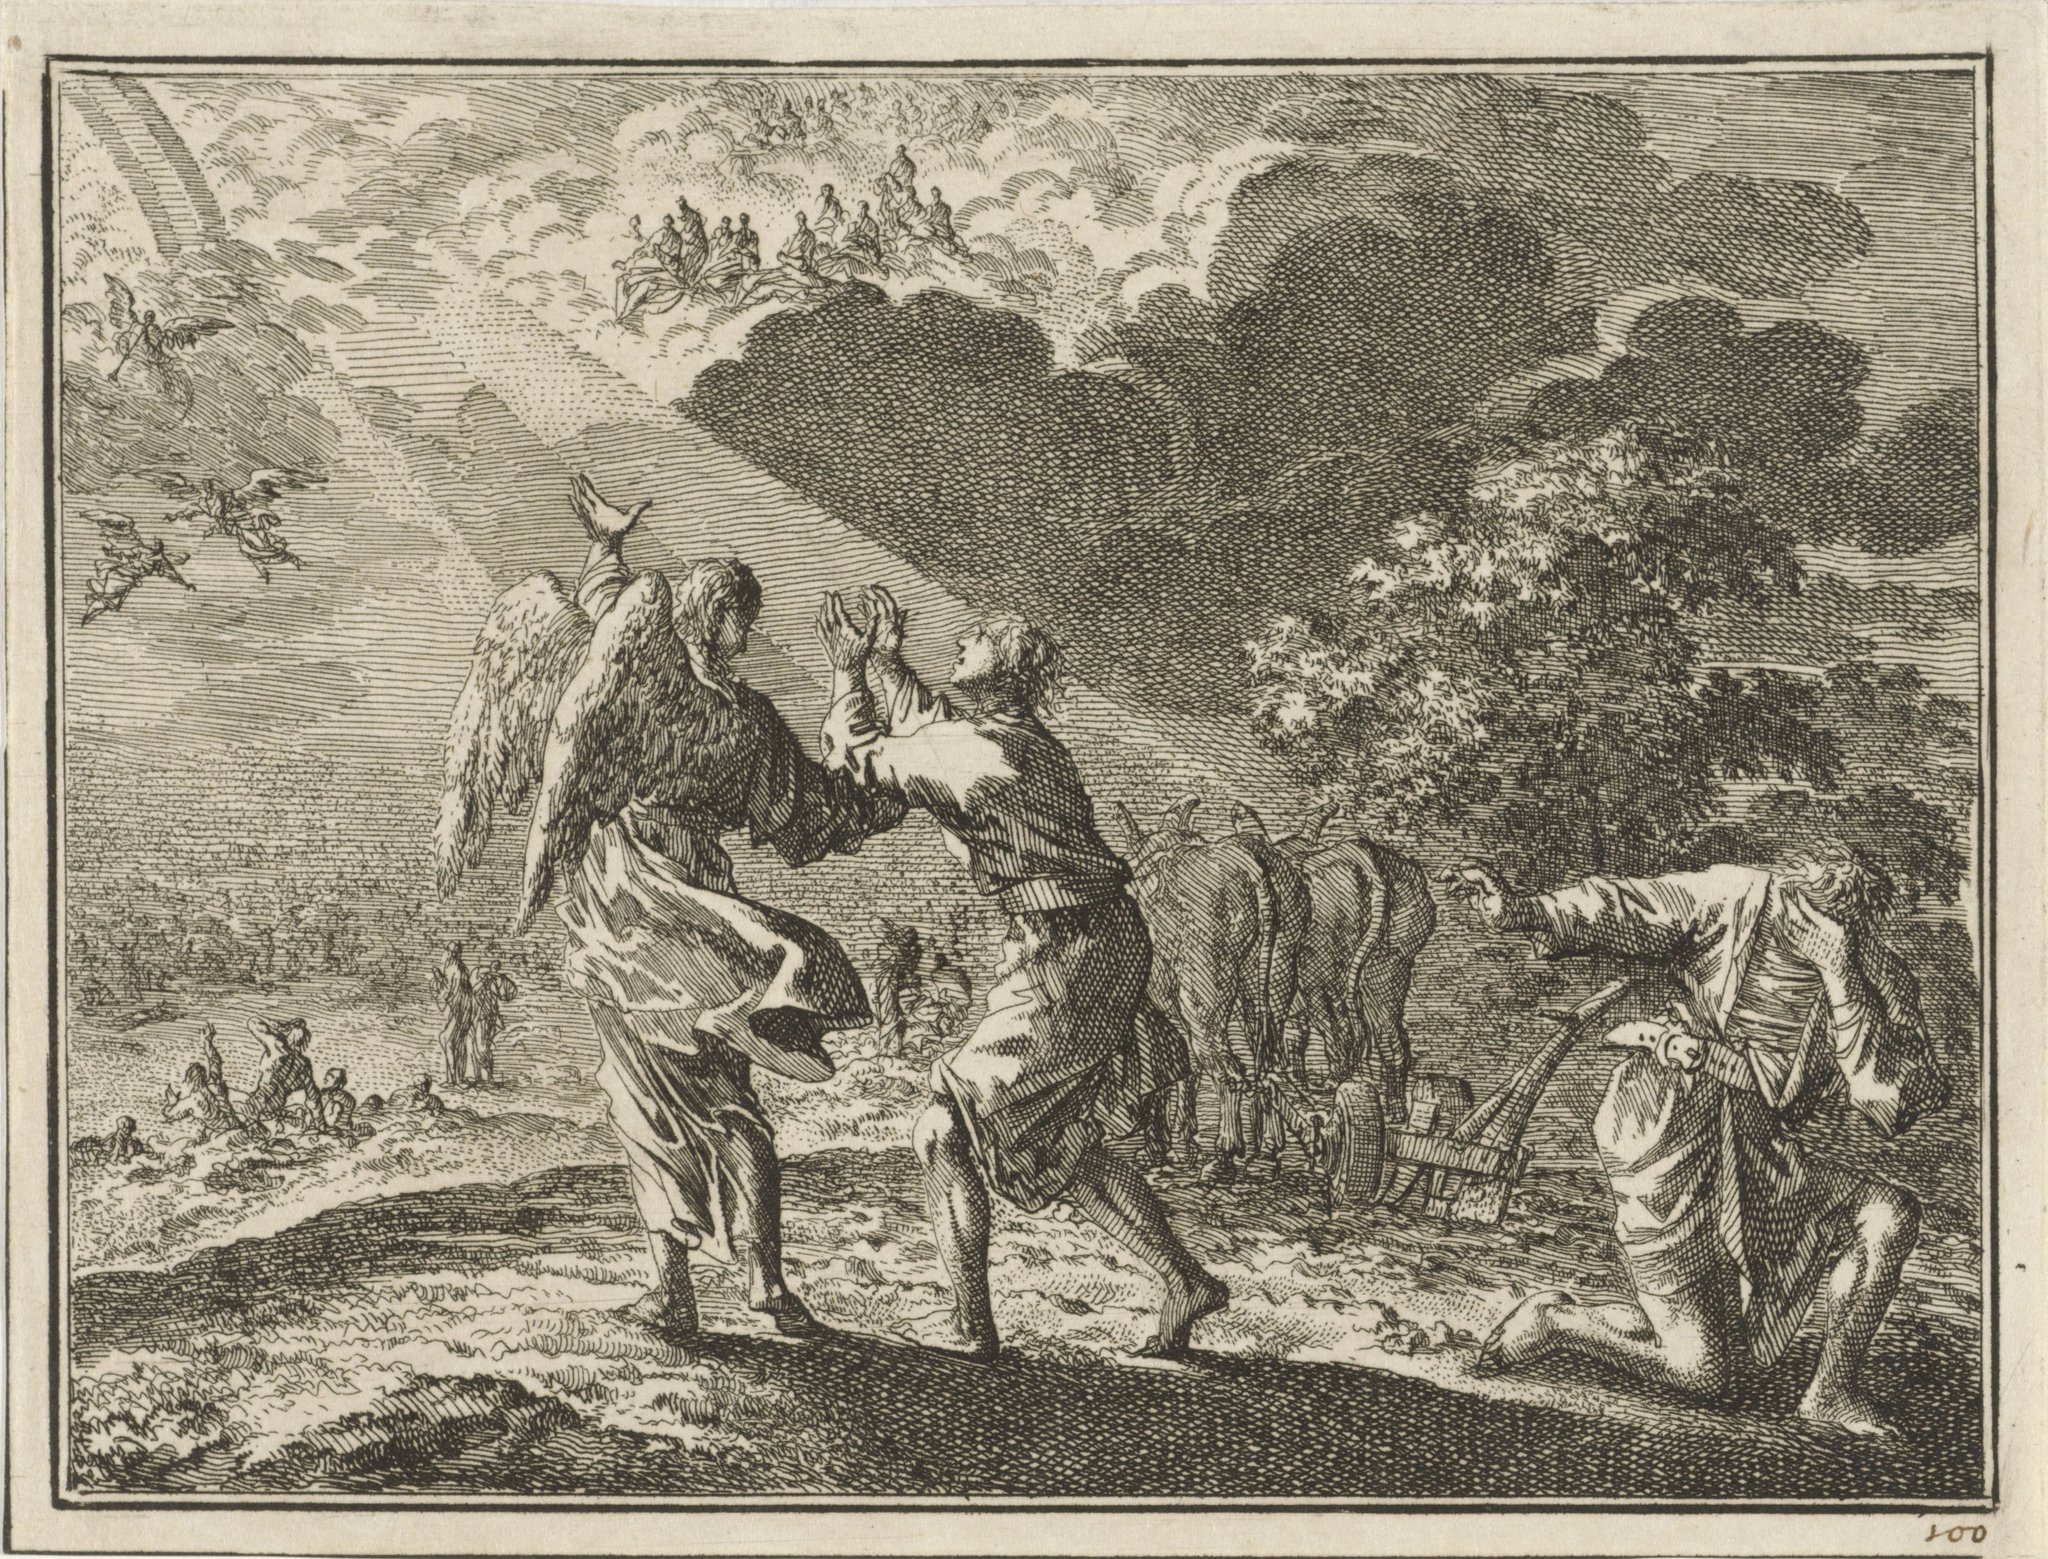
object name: print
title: Van twee op een akker werkende personen wordt één aangenomen en de ander verlaten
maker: jan luyken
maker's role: draughtsman, print maker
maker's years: 1649-1712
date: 1712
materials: paper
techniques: etching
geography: amsterdam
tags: ploughing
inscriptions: number: ‘100’, collector's mark: Lugt 2228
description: Proefdruk van illustratie uit: Luyken, Jan. De schriftuurlyke geschiedenissen en gelykenissen van het Oude en Nieuwe Verbond, 2 delen. Amsterdam: Wed. Pieter Arentsz II en Cornelis van der Sys, 1712, dl. II.